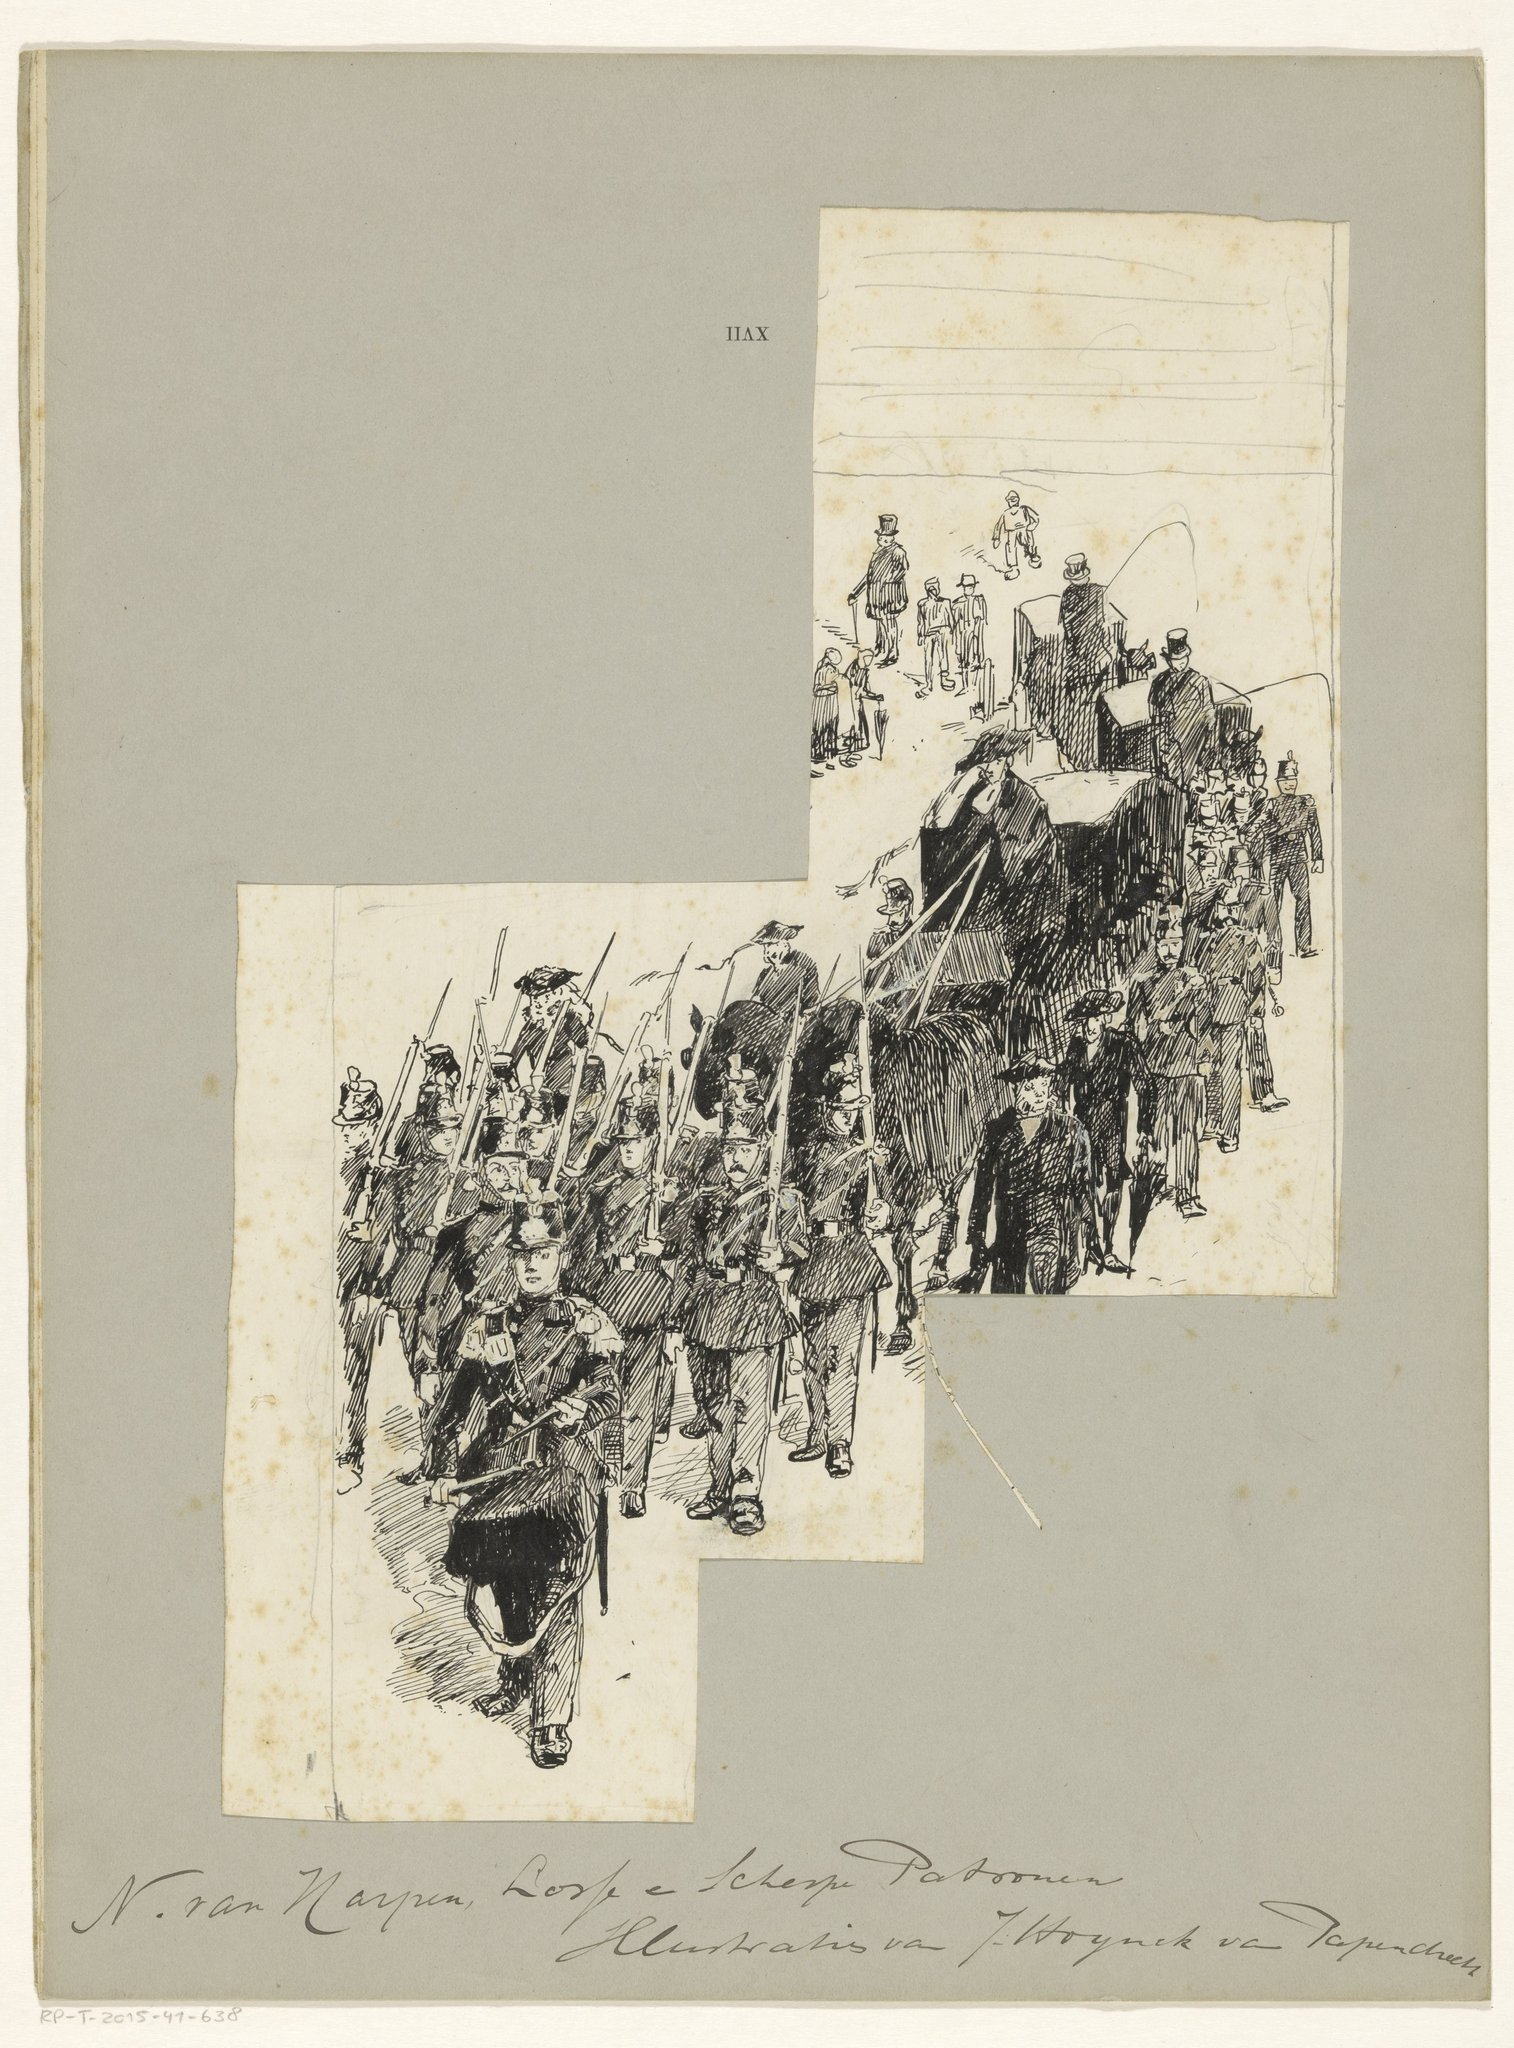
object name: drawing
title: Uitvaart met militaire eer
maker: jan hoynck van papendrecht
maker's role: draughtsman, painter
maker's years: 1858-1933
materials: paint, ink, paper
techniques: brush, pen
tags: military parade, pageant (+ cavalry, horsemen), public funeral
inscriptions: annotation: ‘N. van Harpen, Losse en Scherpe Patronen,/ Illustraties van J. Hoynck van Papendrecht’, collector's mark: Lugt 2228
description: Begrafenisstoet met militairen te voet en te paard. Voorop een man met trommel gevolgd door marcherende militairen en koetsen.